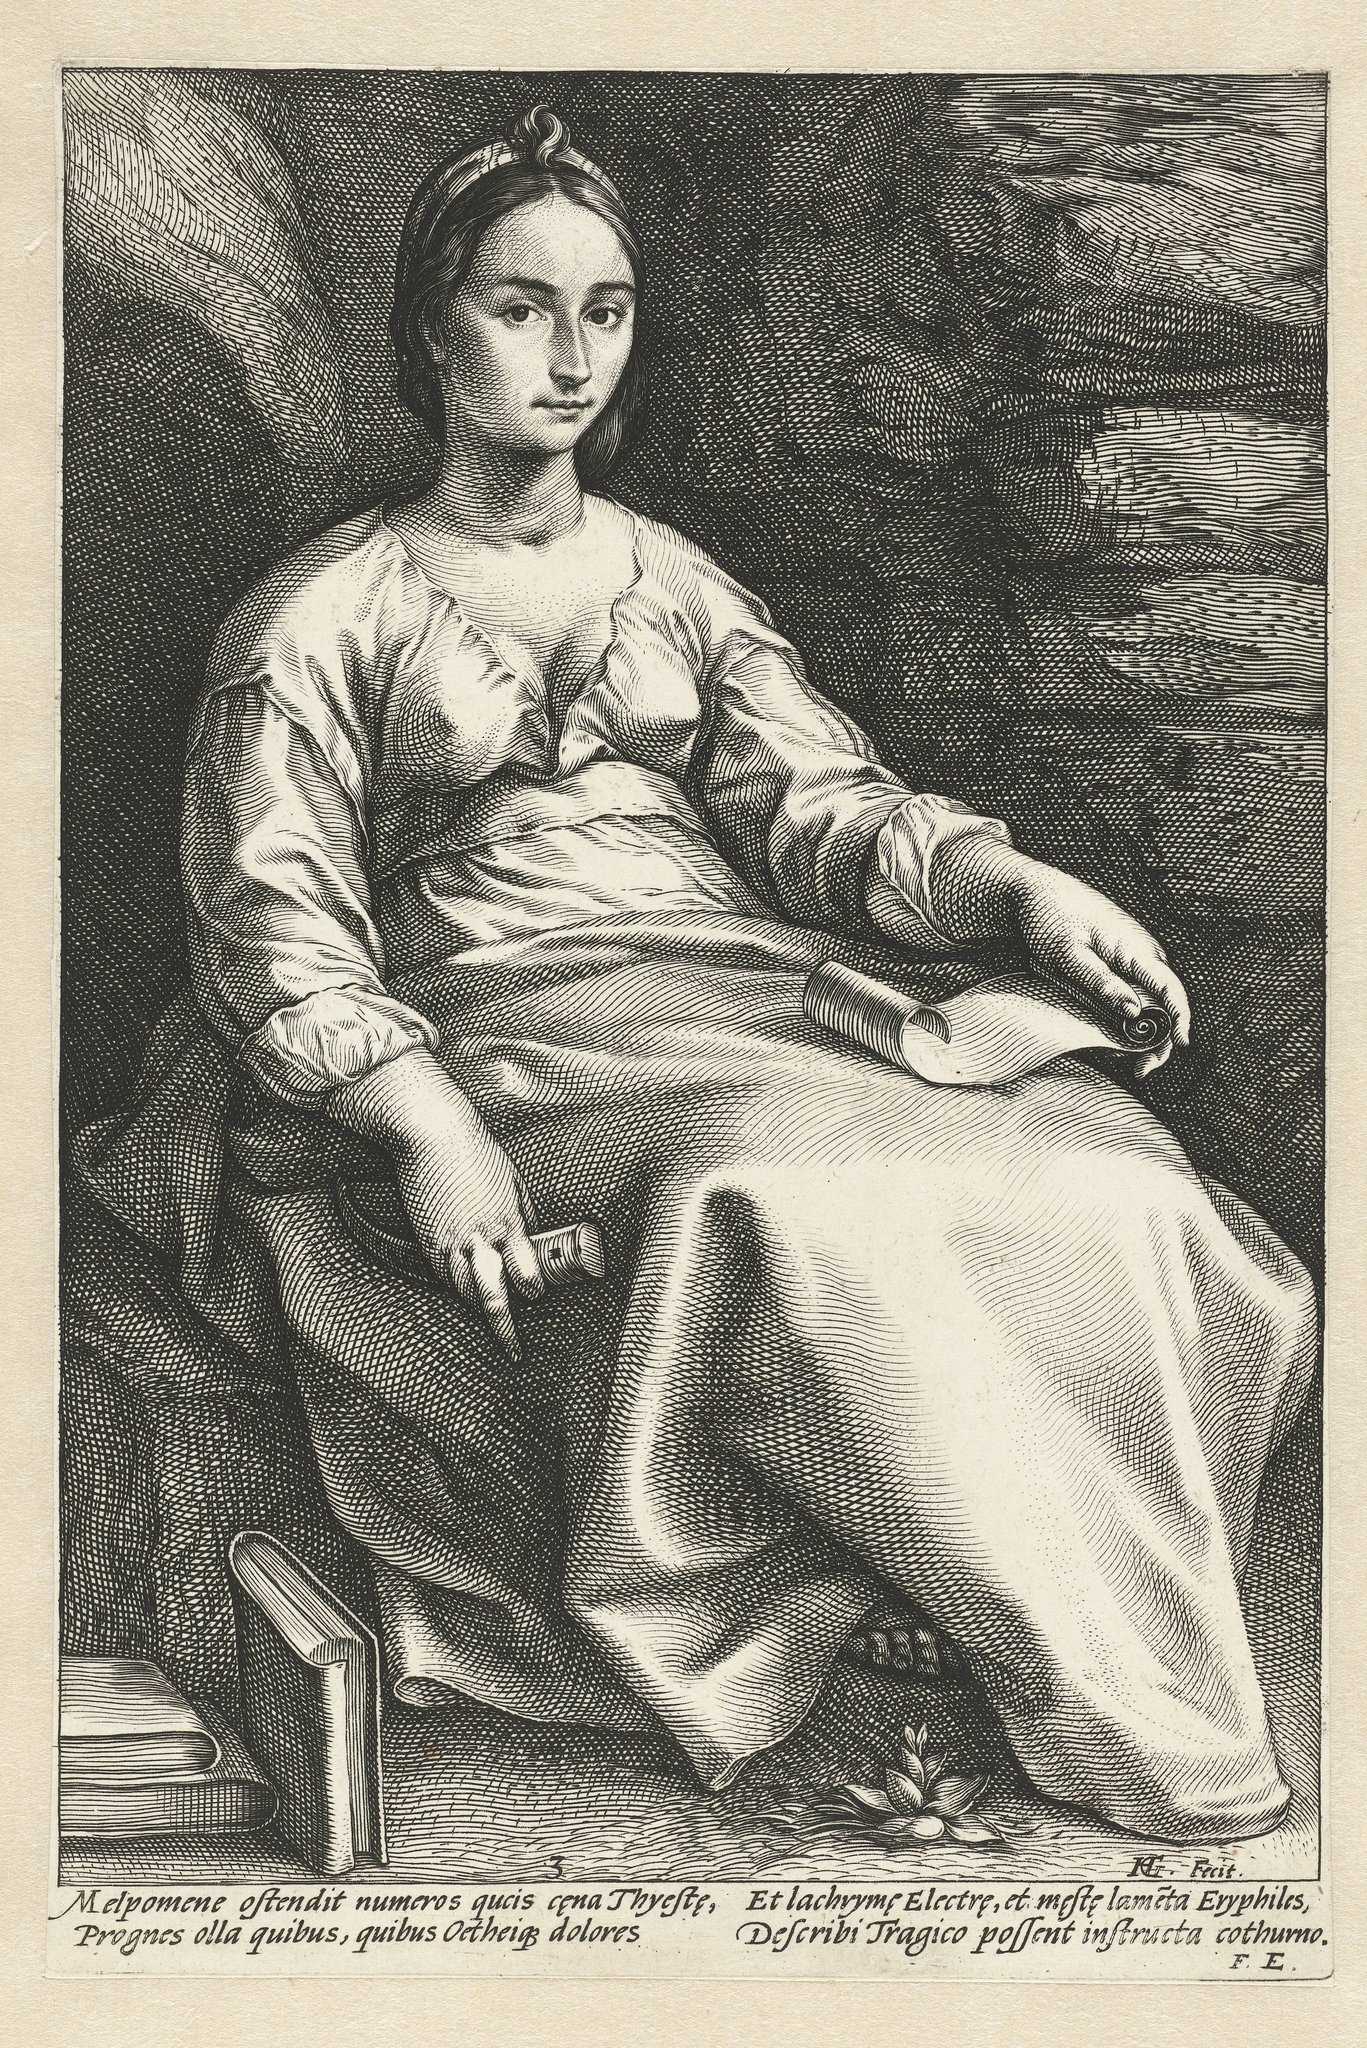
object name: print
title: De negen muzen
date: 1592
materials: paper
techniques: engraving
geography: haarlem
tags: melpomene (one of the muses); 'melpomene' (ripa)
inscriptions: signature: ‘F.E.’, collector's mark: Lugt 2228a, signature: ‘HG. Fecit.’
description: Een serie van negen muzen. Vier regels Latijn van Franco Estius in marge onder prent.